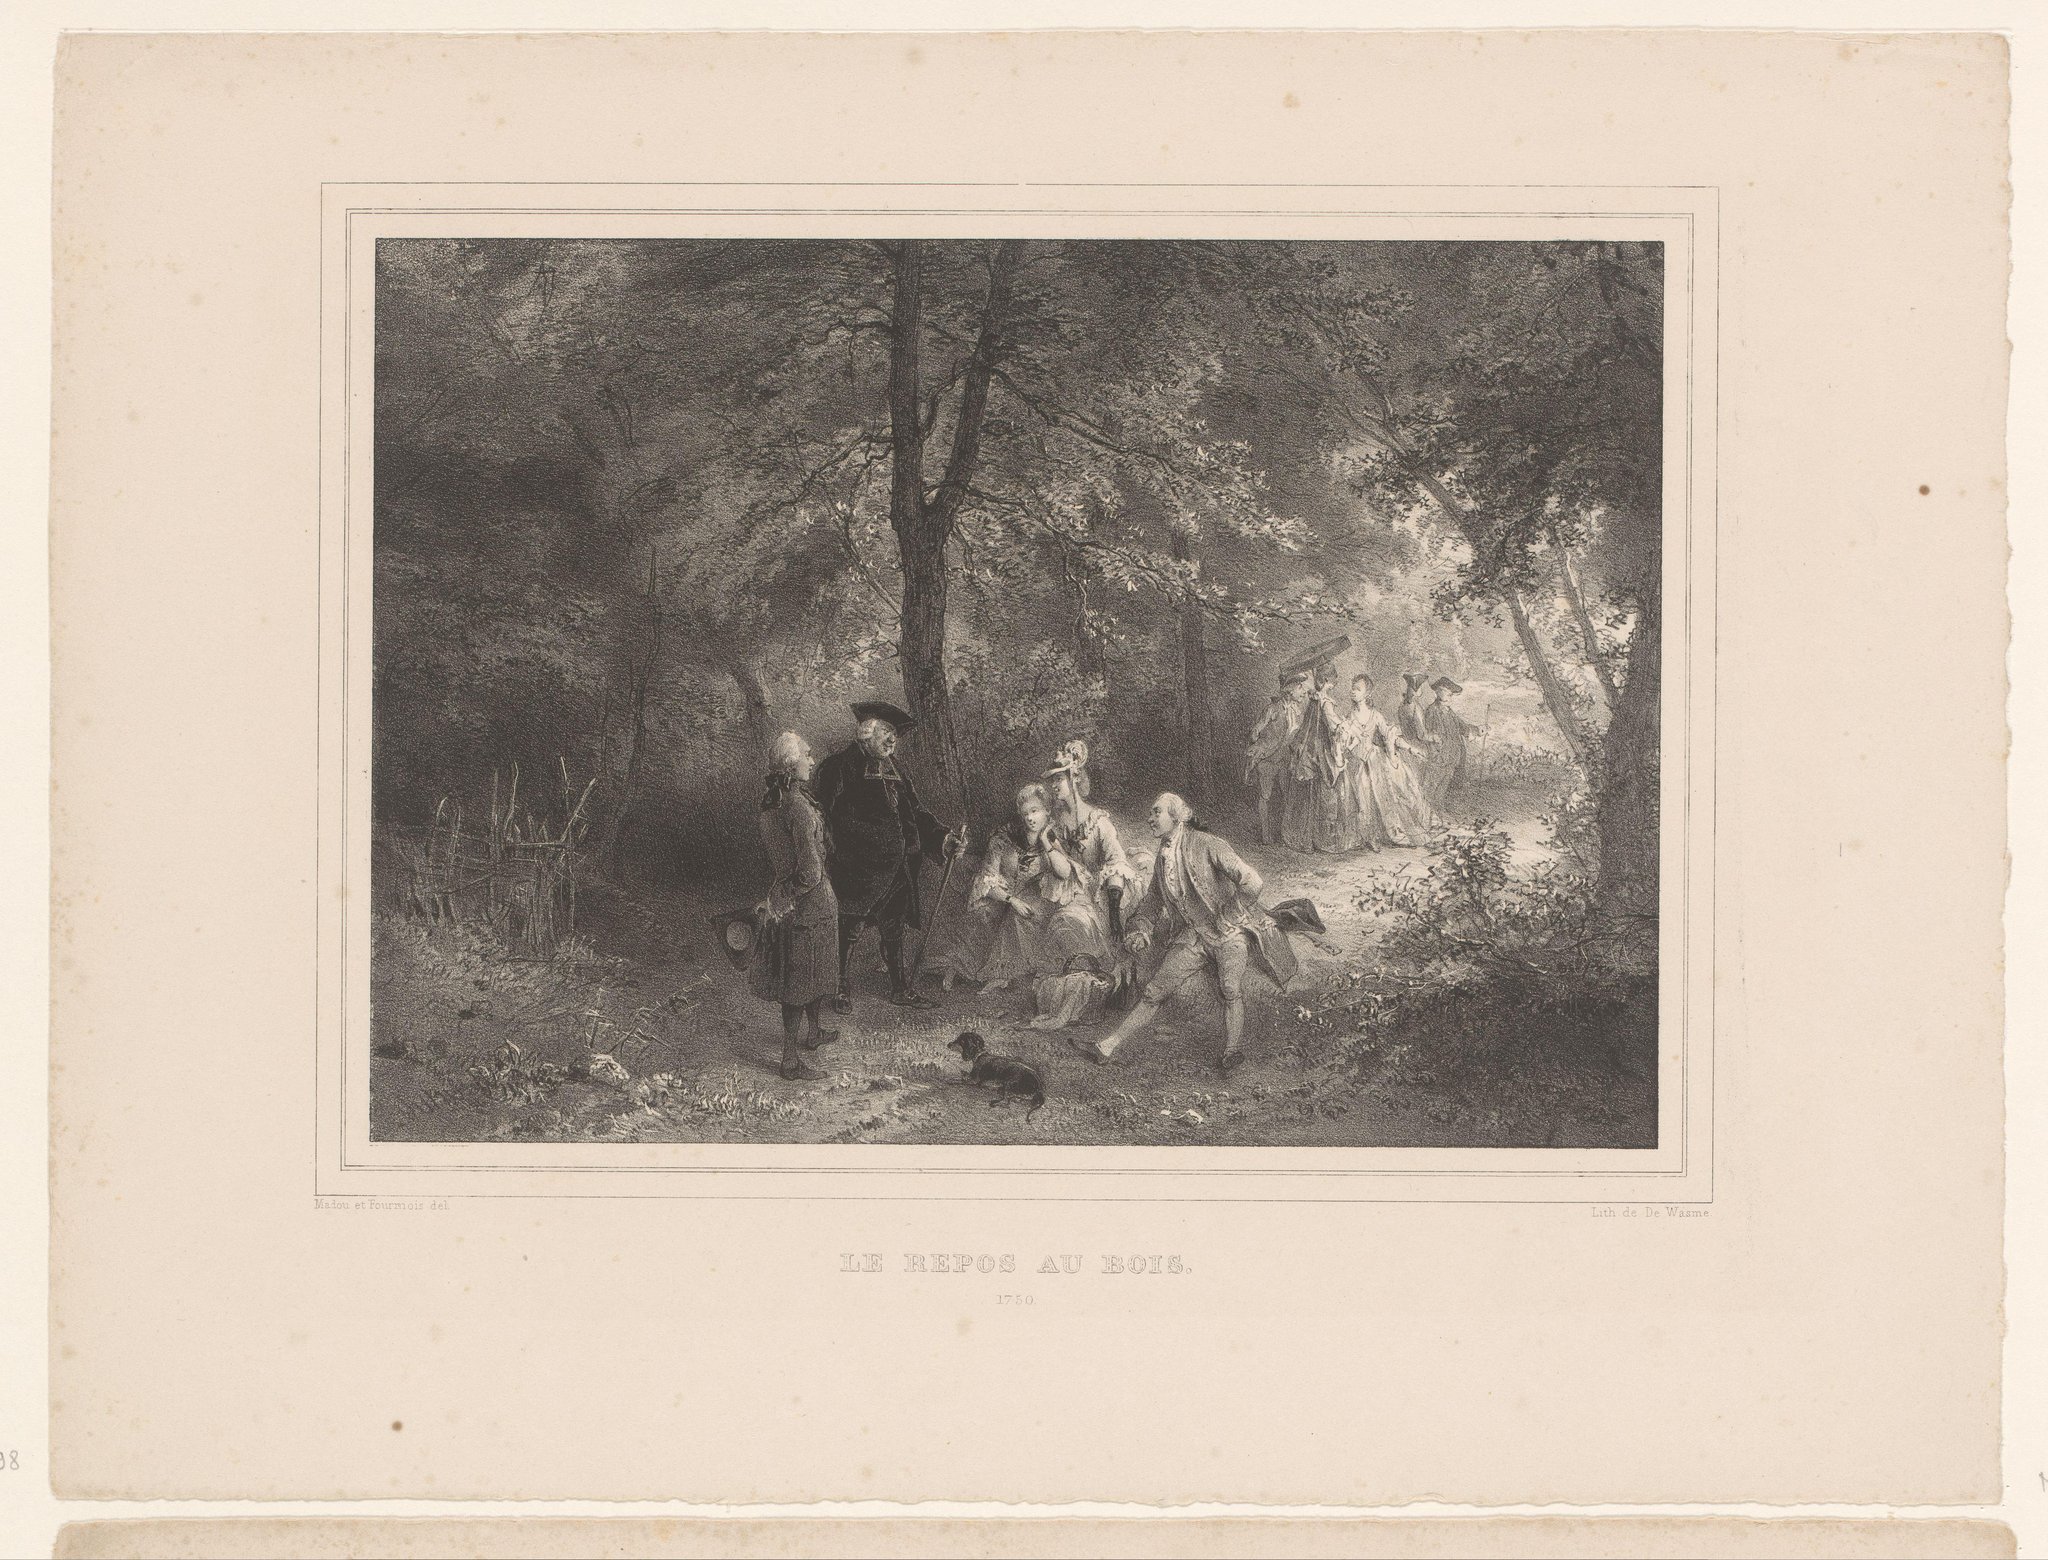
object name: print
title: Twaalf genretaferelen door Jean Baptiste Madou en Théodore Fourmois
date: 1834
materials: paper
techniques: lithograph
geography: brussels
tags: forest, wood, resting - bb - out of doors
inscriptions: collector's mark: Lugt 2228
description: Prent behoort tot een serie met twaalf genretaferelen vervaardigd door Madou en Fourmois. Vier prenten zijn enkel door Madou vervaardigd en de overige prenten door Madou en Fourmois samen. Madou vervaardigde de figuren en Fourmois het landschap.